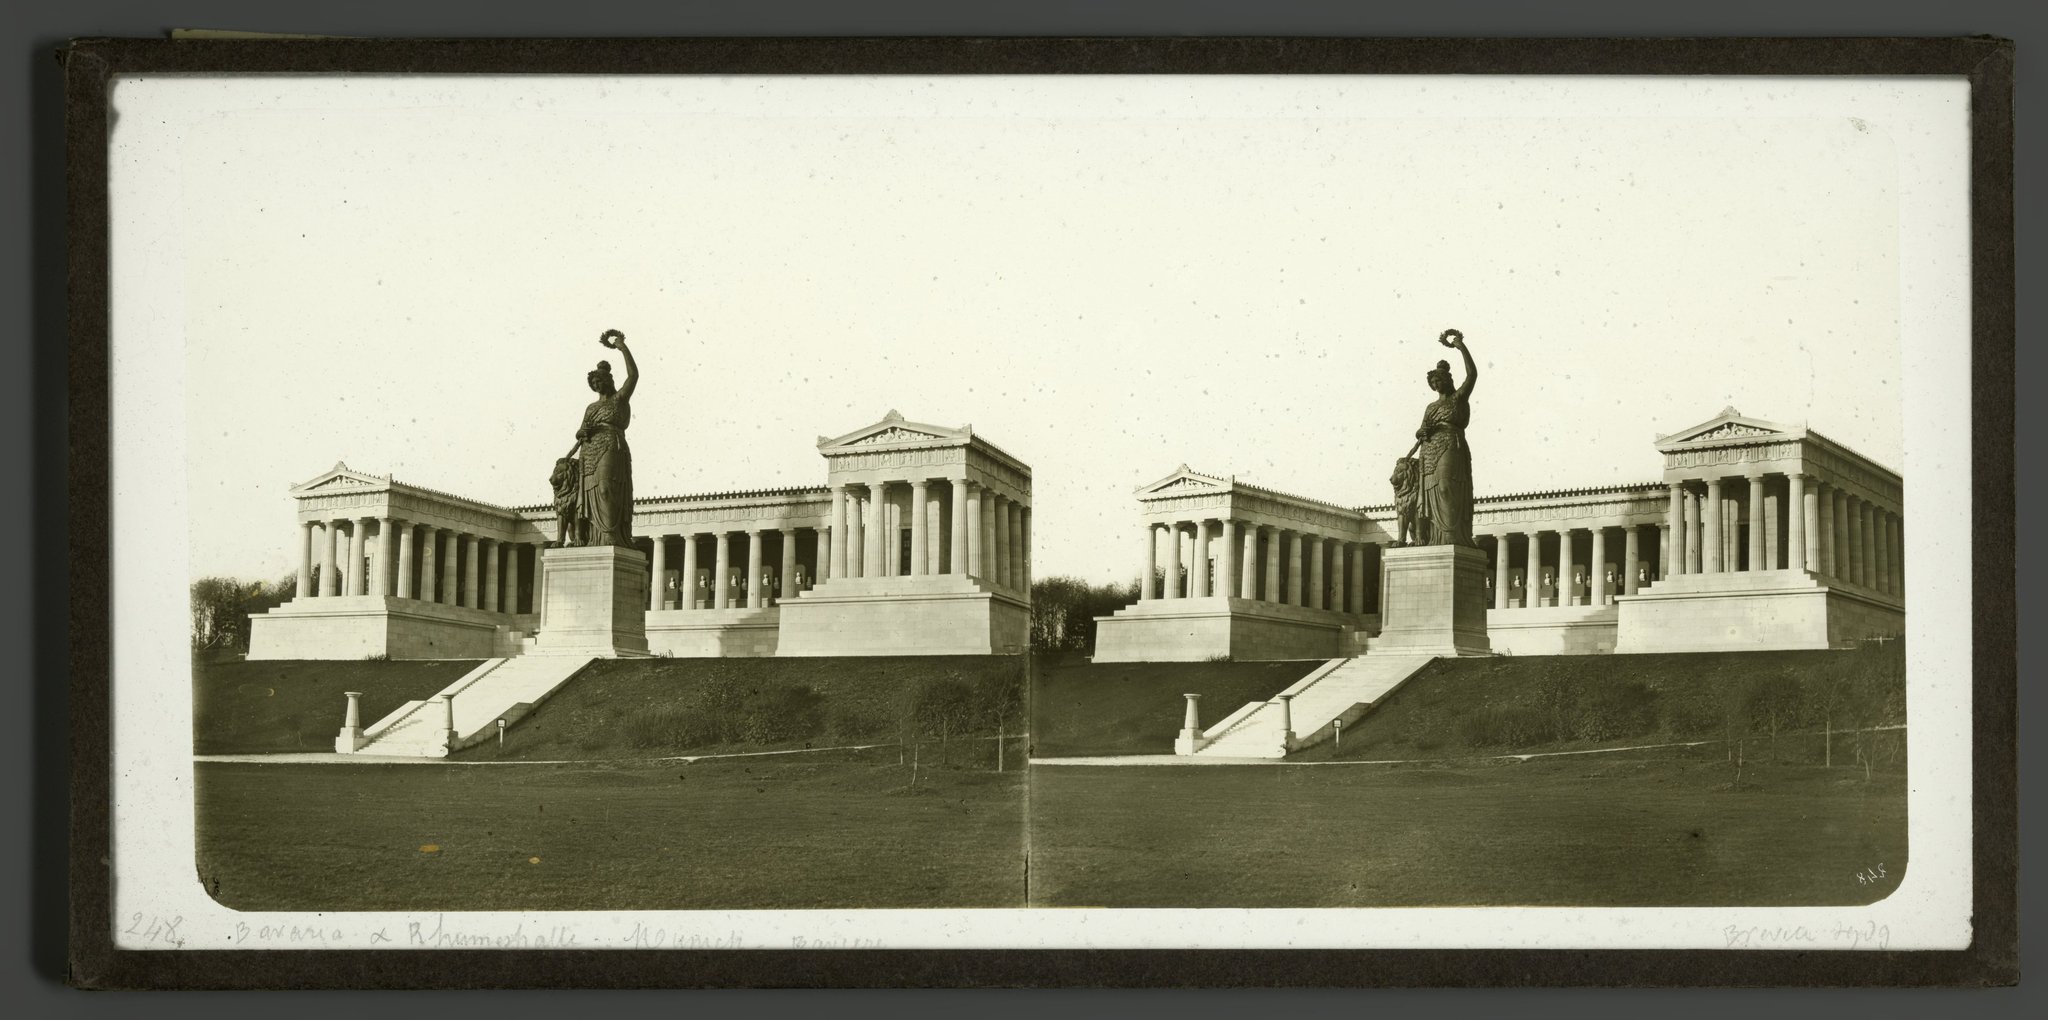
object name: photograph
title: Bavaria x Ruhmeshalle, Munich, Baviere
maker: ferrier père-fils et soulier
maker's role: publisher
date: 1860-1890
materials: glass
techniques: slide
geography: munich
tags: palace, monument, statue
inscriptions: number: ‘248’, inscription: ‘Brevete sgdg’